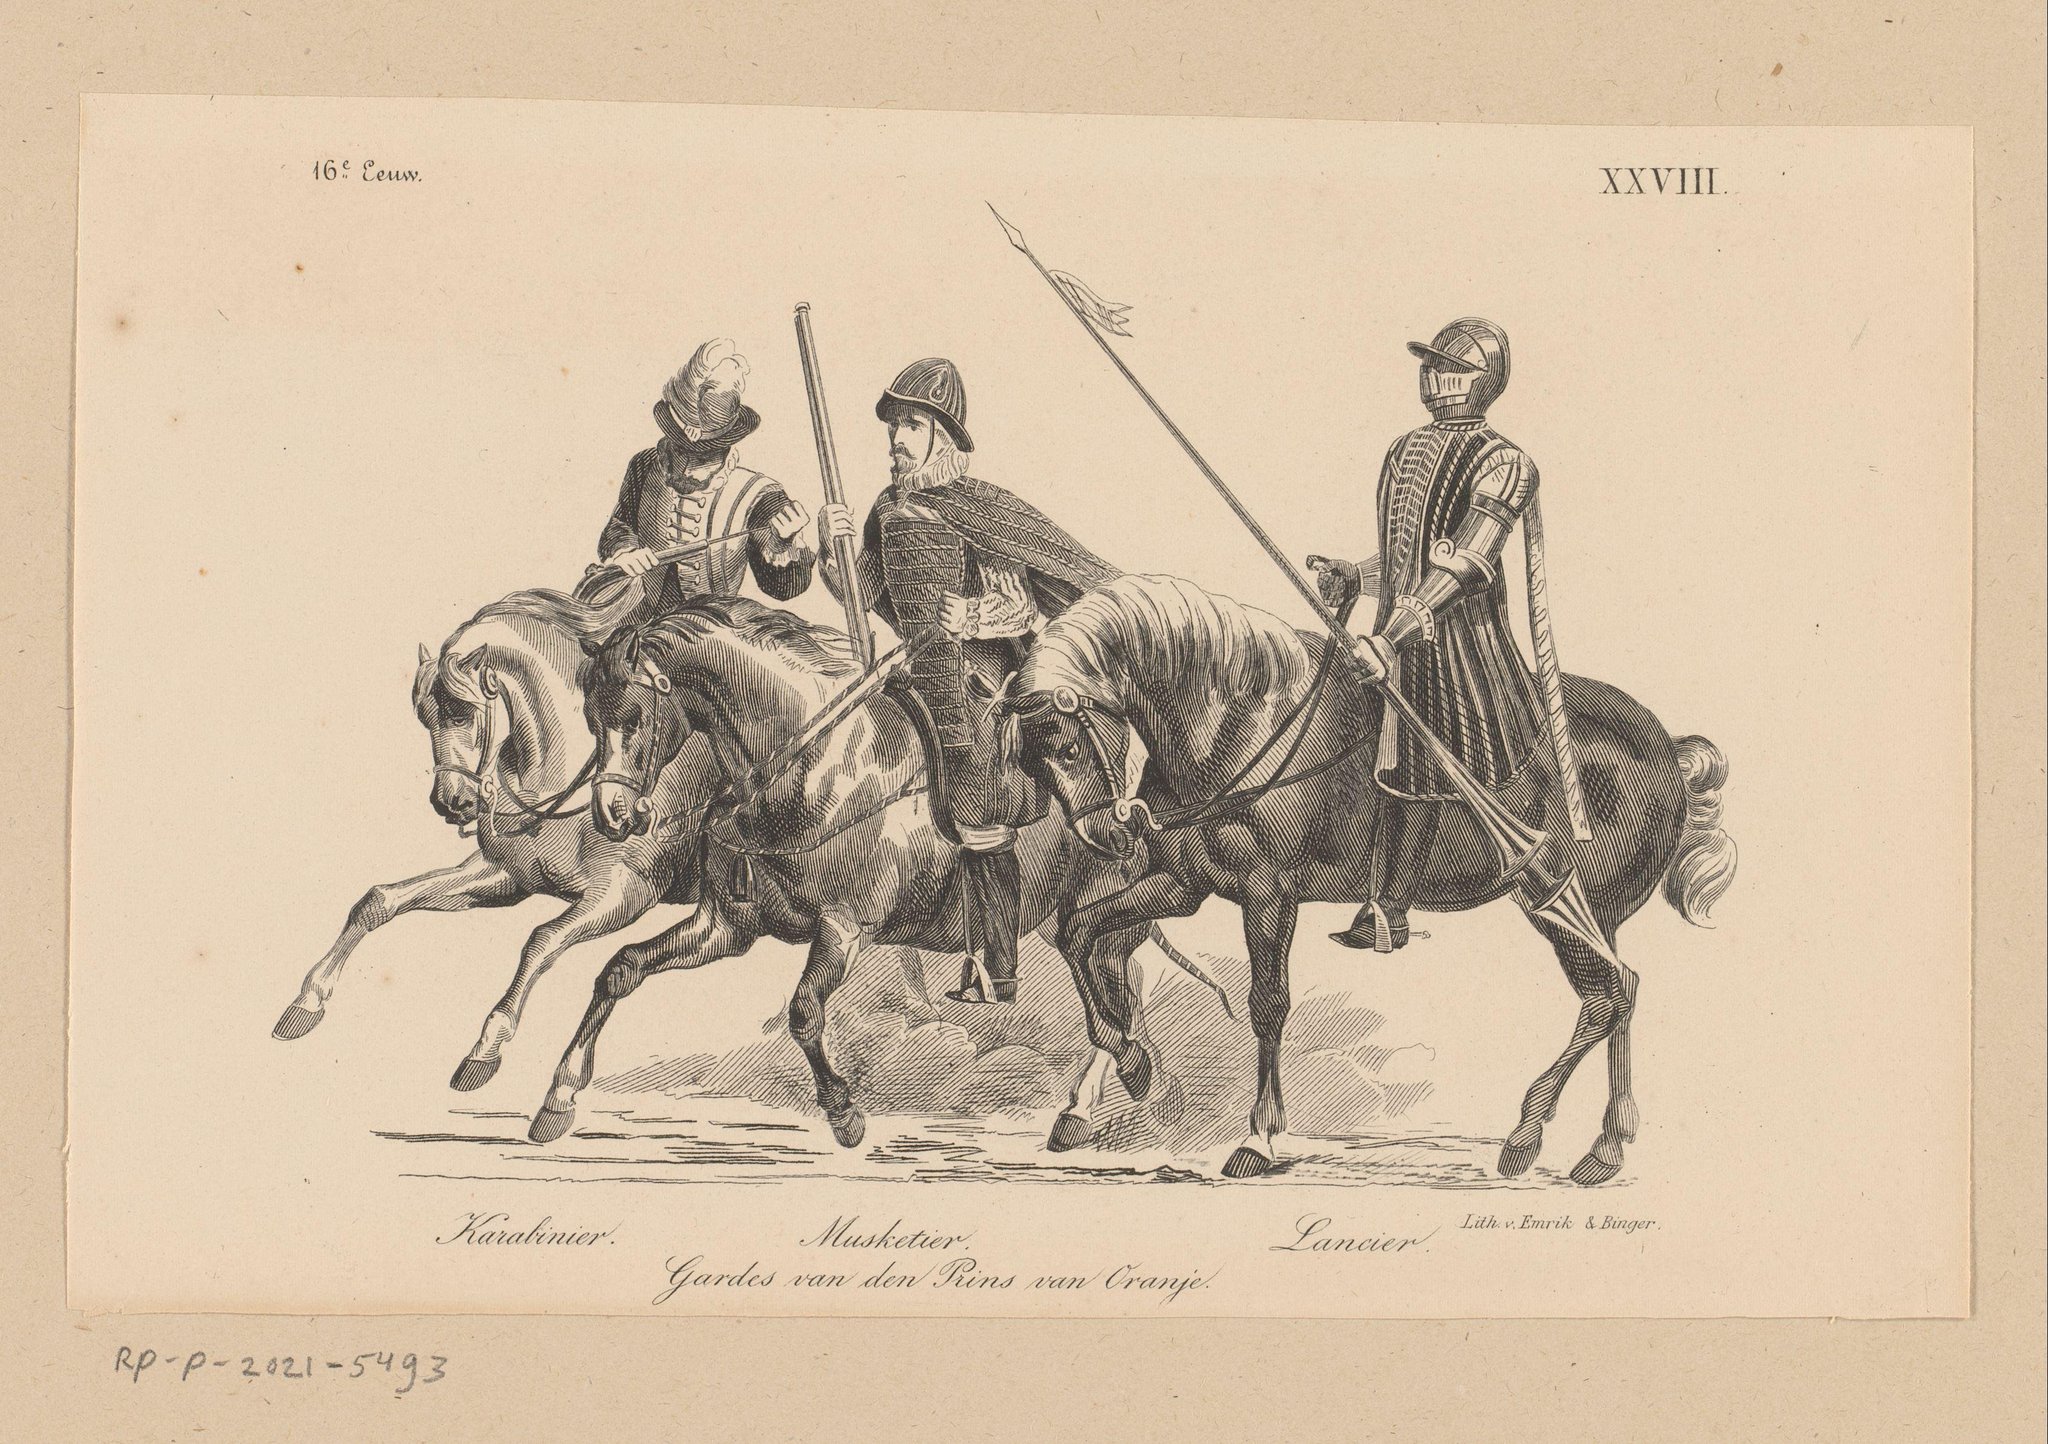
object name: book illustration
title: Karabinier, musketier en lansier te paard in kleding uit de zestiende eeuw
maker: Anonymous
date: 1857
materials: paper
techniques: lithograph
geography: netherlands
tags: riding a horse, ass, or mule; rider, horseman, clothes, costume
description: Prent waarschijnlijk uit: Hofdijk, Willem Jacob. Schets van de geschiedenis der Nederlanden. Amsterdam: Gebroeders Binger, 1857.